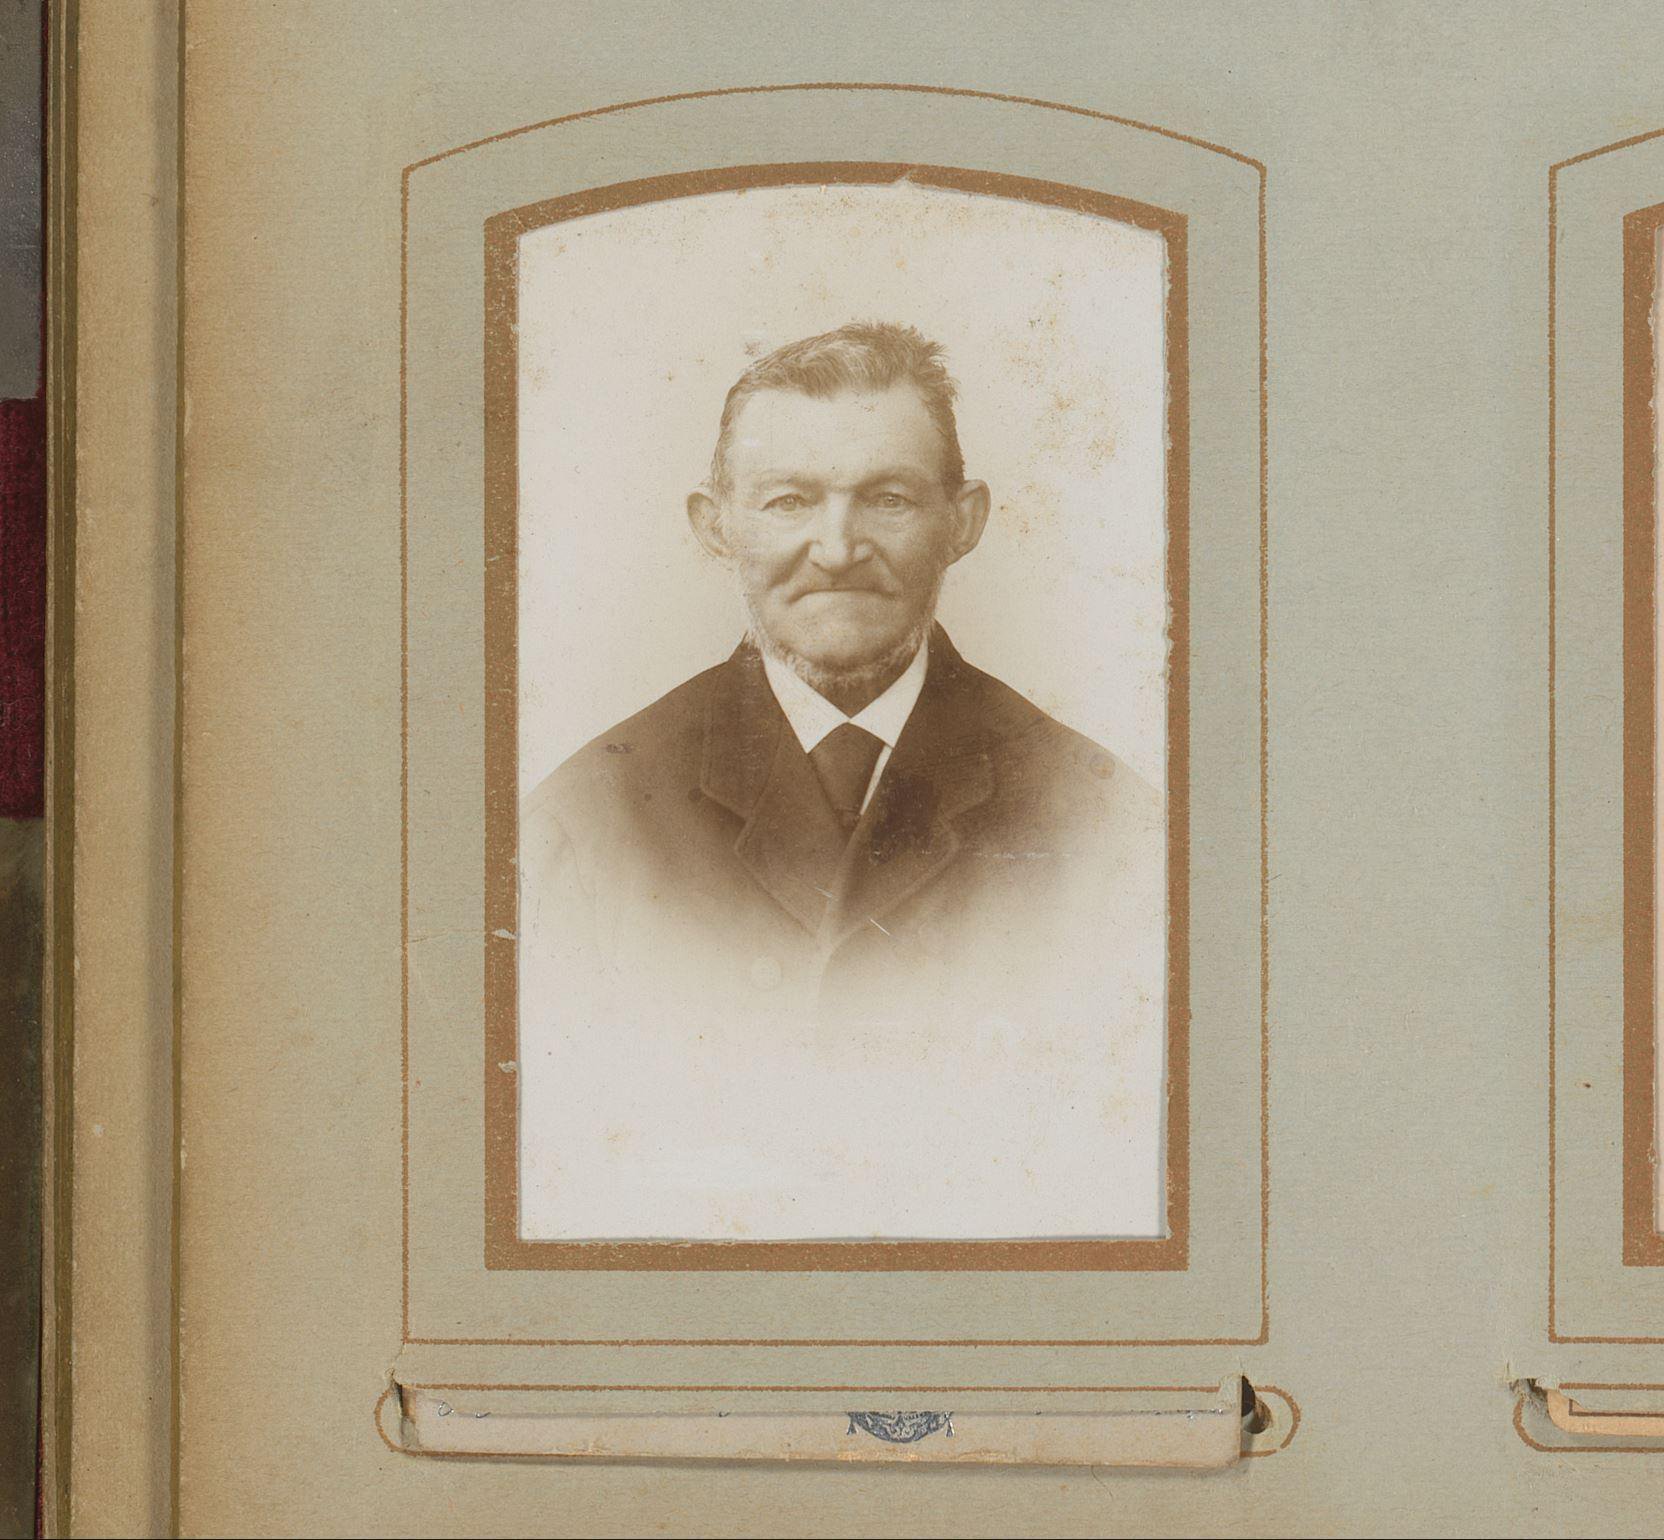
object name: album leaf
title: Portret van een man met baard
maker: johannes jacobus van ravesteijn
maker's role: fotograaf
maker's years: 1856-1903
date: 1886-1903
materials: cardboard, photographic support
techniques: collodion silver print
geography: rotterdam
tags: historical persons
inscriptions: inscription: ‘J.J. van Ravesteijn/ Rotterdam/ Verlengde Goudsche Rijweg 86’